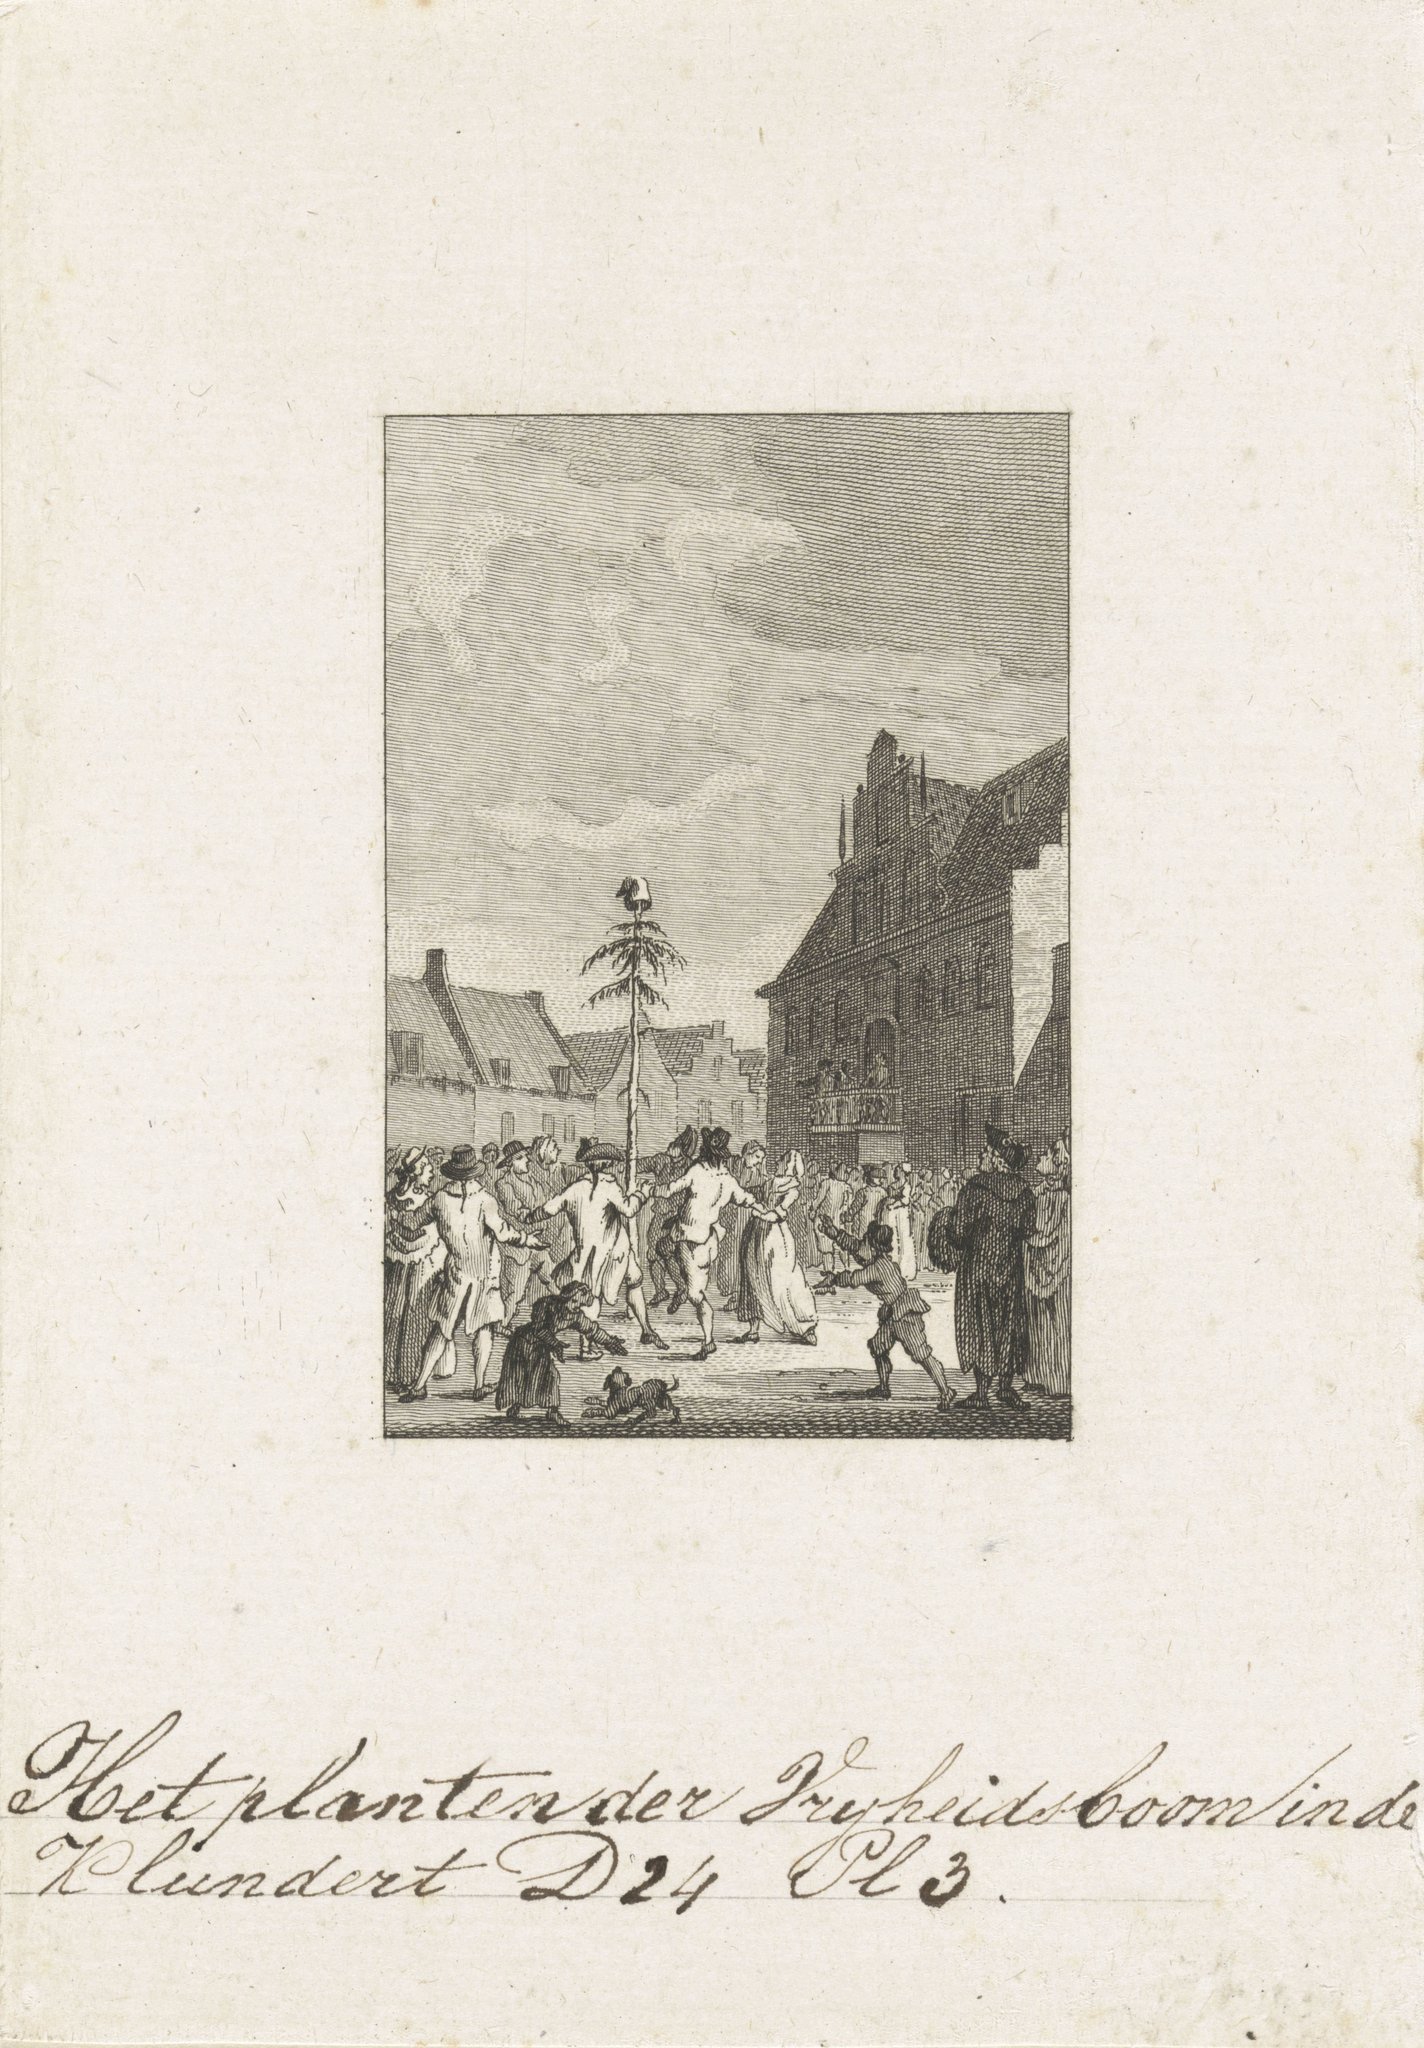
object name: print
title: Oprichten van vrijheidsboom te Klundert, 1793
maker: cornelis bogerts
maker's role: print maker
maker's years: 1745-1817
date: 1793-1795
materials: paper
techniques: engraving, etching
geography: northern netherlands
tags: dancing around the tree of liberty, klundert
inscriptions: collector's mark: Lugt 2228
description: Gebruikt als illustratie in: J. Fokke, Geschiedenissen der Vereenigde Nederlanden voor de vaderlandsche jeugd, Johannes Allart, Amsterdam 1783-1795, 25 delen, dl. 24, pl. 3.